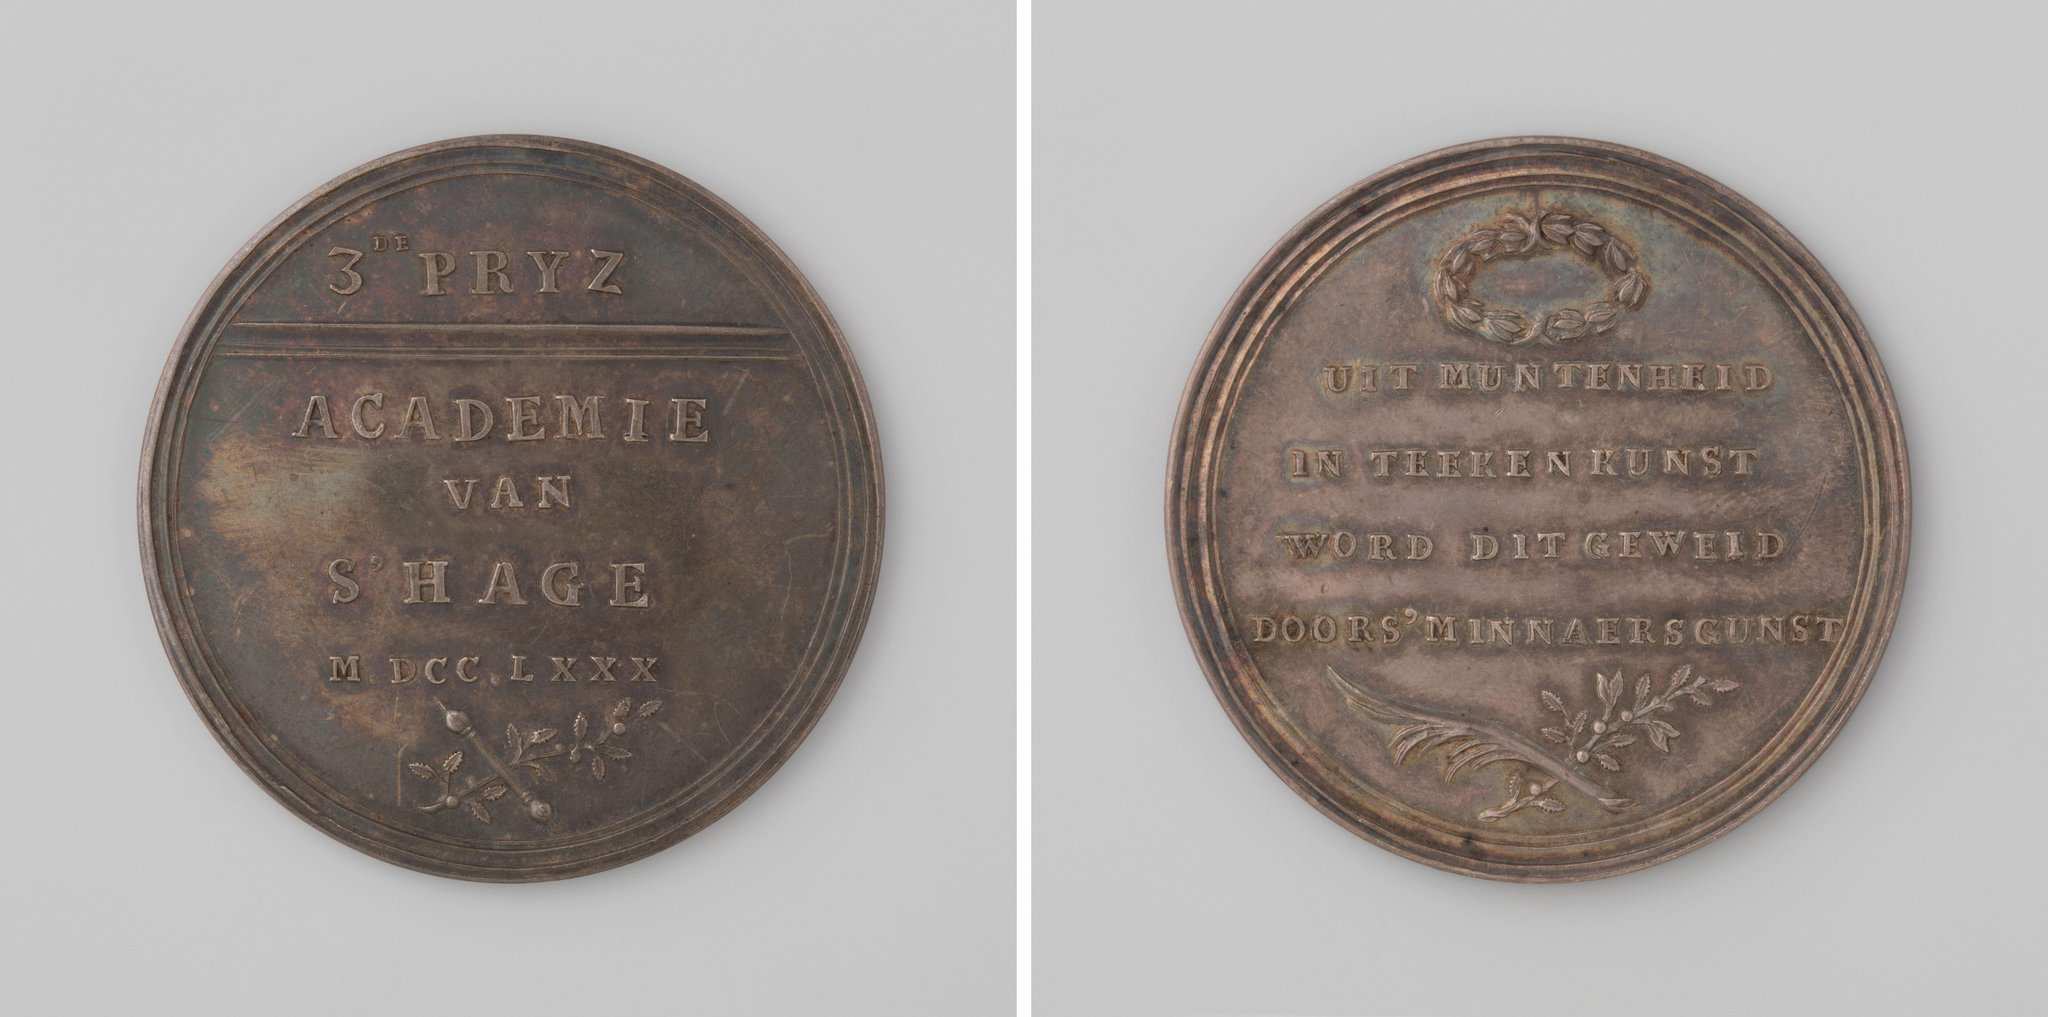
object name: medal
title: Tekenakademie Pictura te 's-Gravenhage, penning uitgereikt als derde prijs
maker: Anonymous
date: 1780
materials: silver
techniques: striking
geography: the hague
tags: schools, the hague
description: Zilveren penning. Voorzijde: opschrift door horizontale lijn in twee vlakken verdeeld boven gekruiste myrtetak en dubbele tekenpen. Keerzijde: opschrift onder lauwerkrans, boven gekruiste palm- en myrtetak.